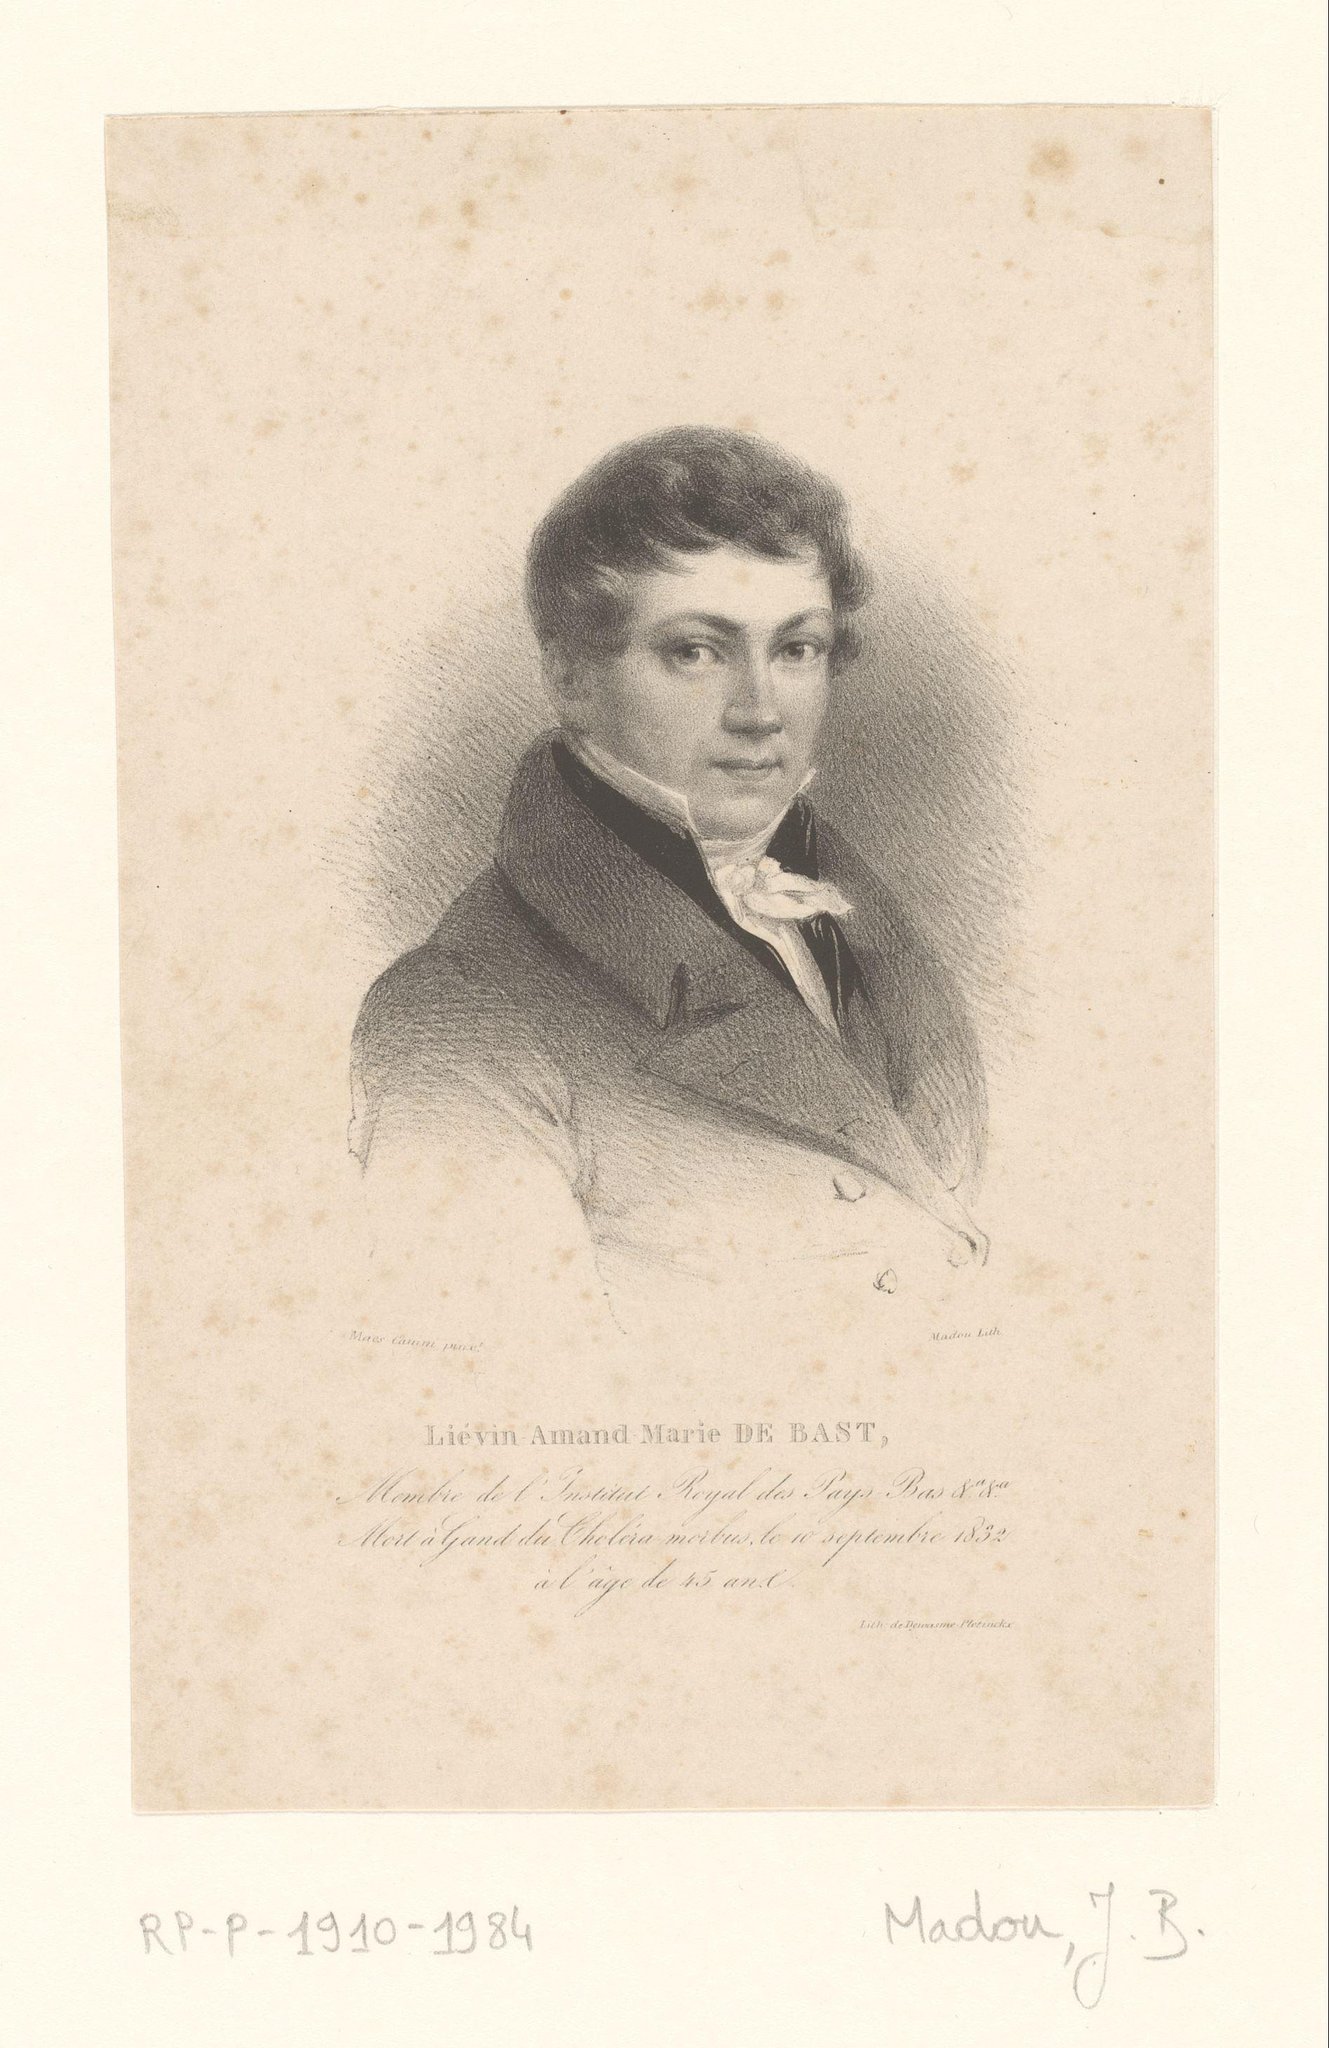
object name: print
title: Liévin Amand Marie de Bast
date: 1827-1851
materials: paper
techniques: lithograph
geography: brussels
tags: ghent, print maker, liévin amand marie de bast, historical persons, youth, adolescent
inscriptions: collector's mark: Lugt 2228